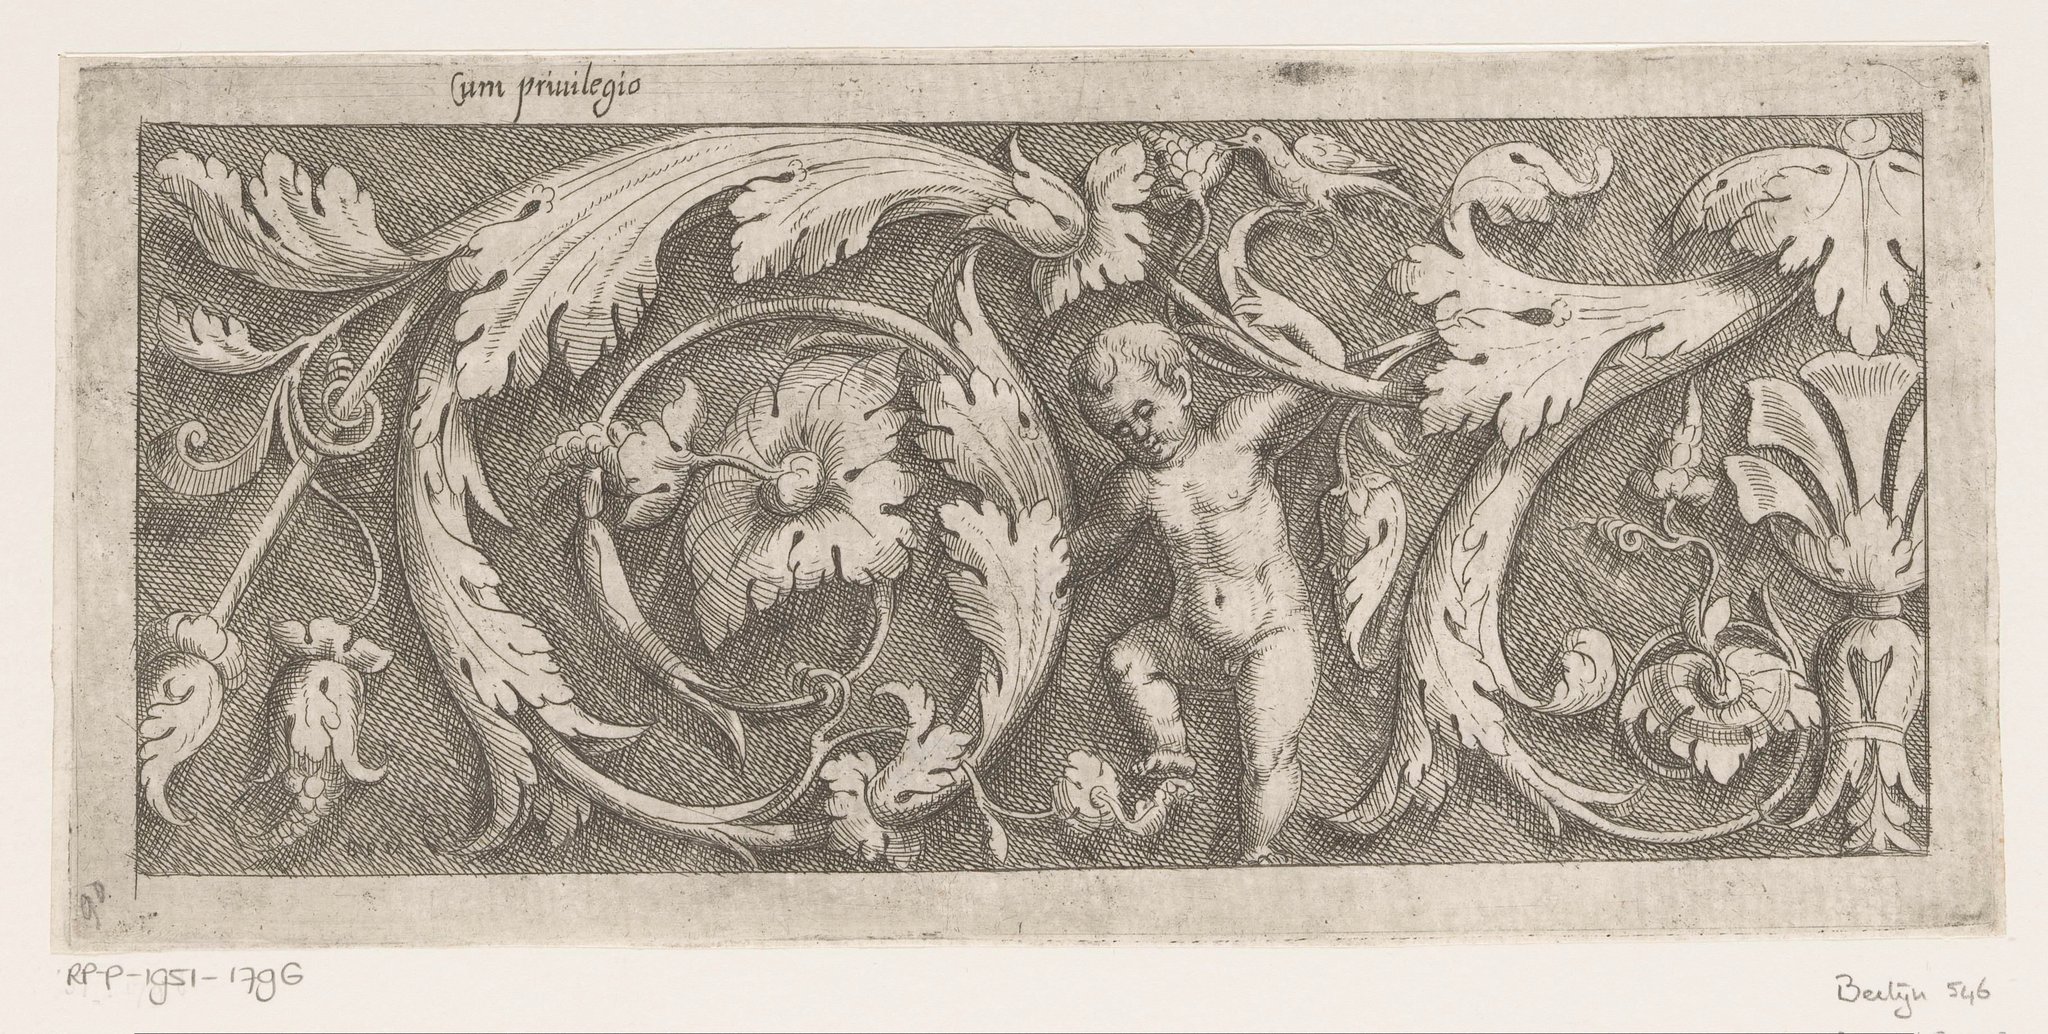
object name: print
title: Ornamentele friezen met arabesken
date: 1561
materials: paper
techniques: etching, intaglio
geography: italy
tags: ornaments ~ art, foliage ~ ornament, cupids: 'amores', 'amoretti', 'putti'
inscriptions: collector's mark: Lugt 2228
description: Deze prent maakt onderdeel uit van een reeks.